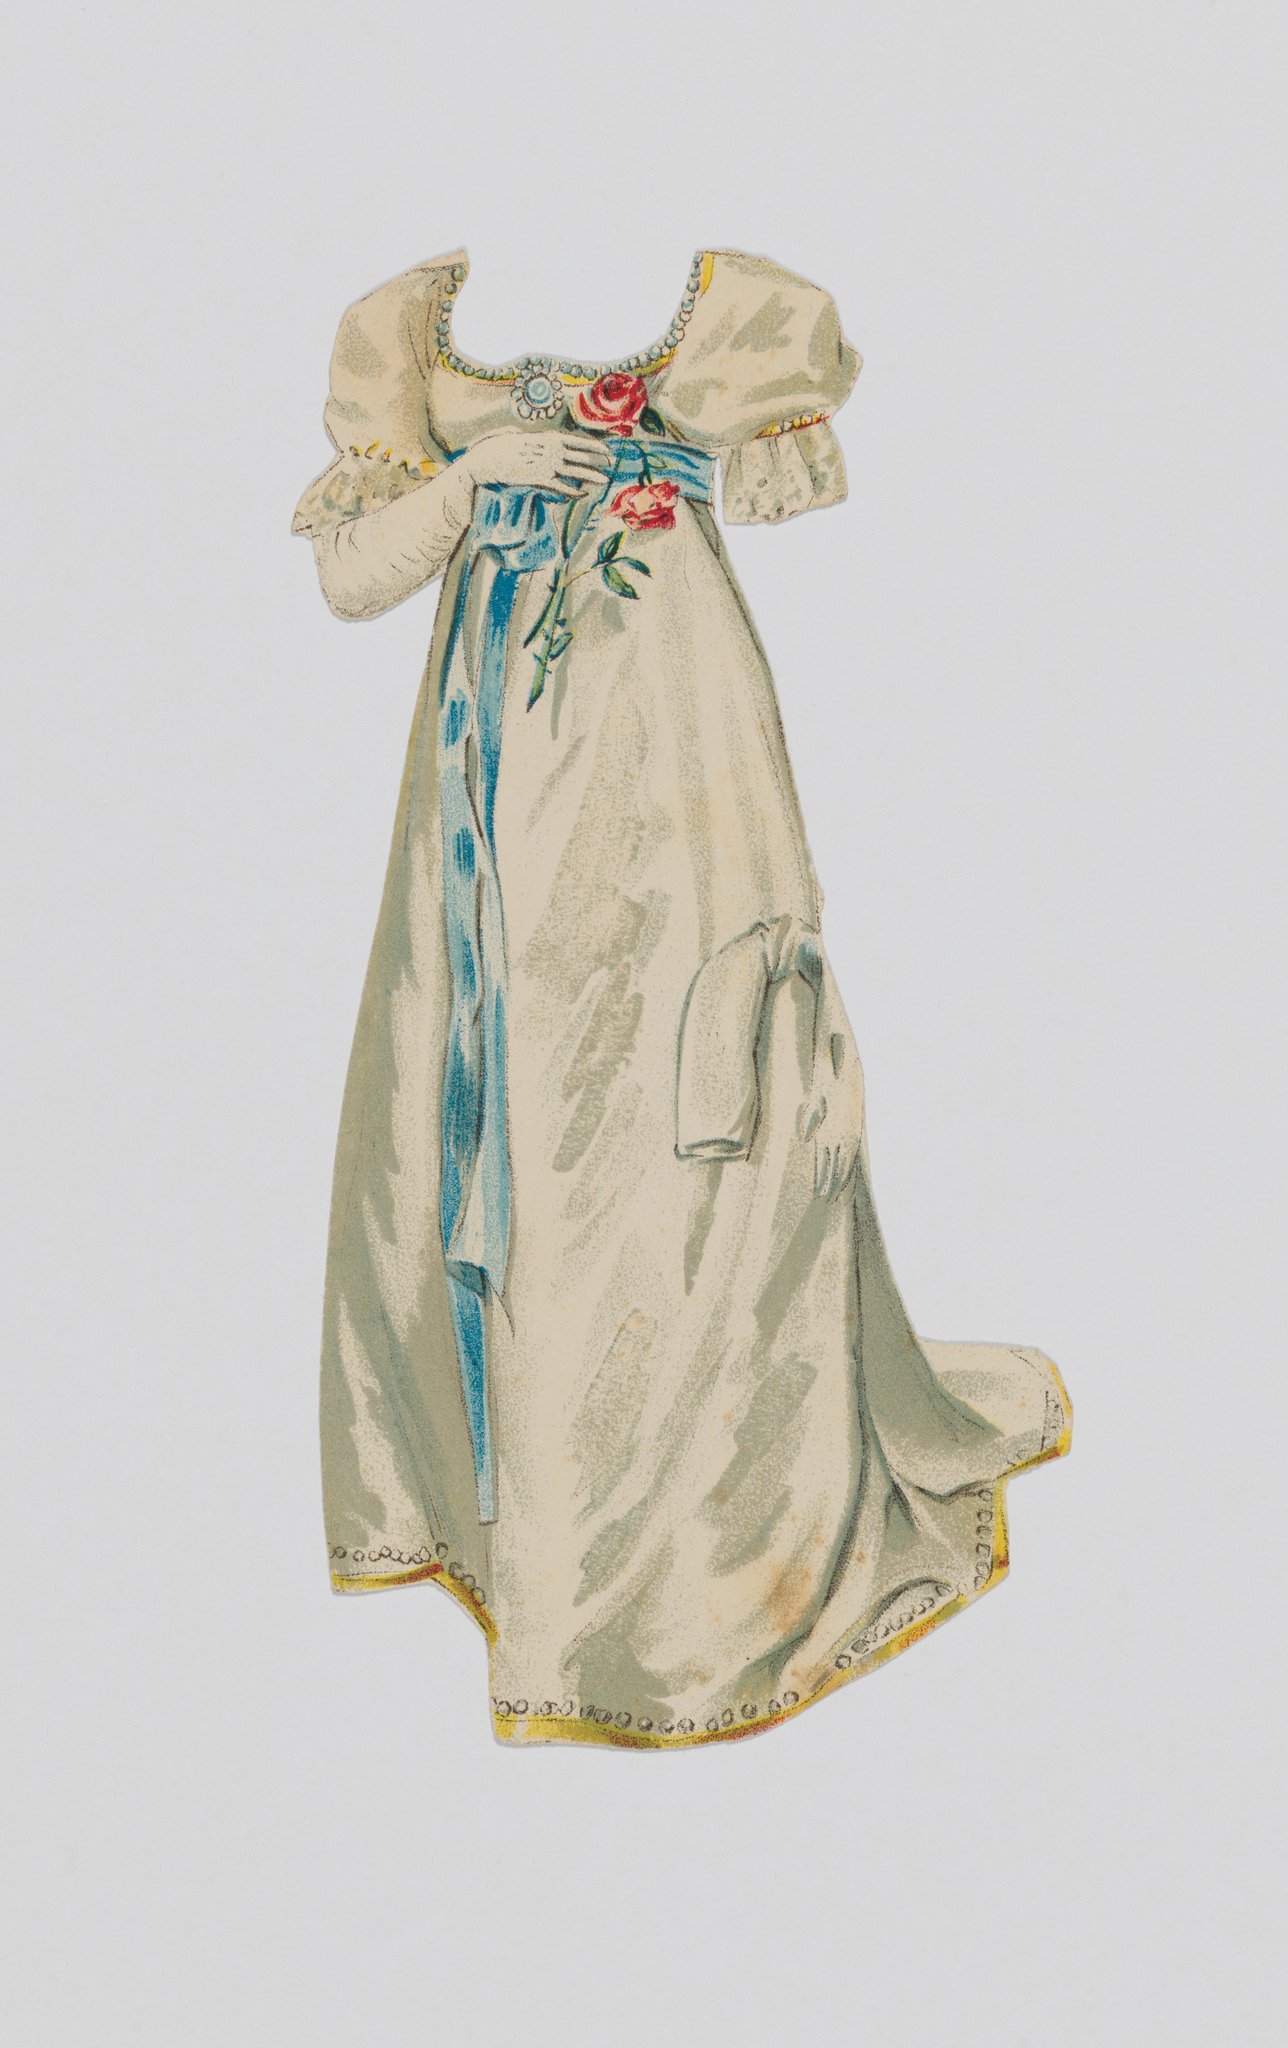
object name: paper doll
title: Queen Louise Reception Gown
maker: elizabeth s. tucker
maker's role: artist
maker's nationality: american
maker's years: 1850-1930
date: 1895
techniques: lithograph